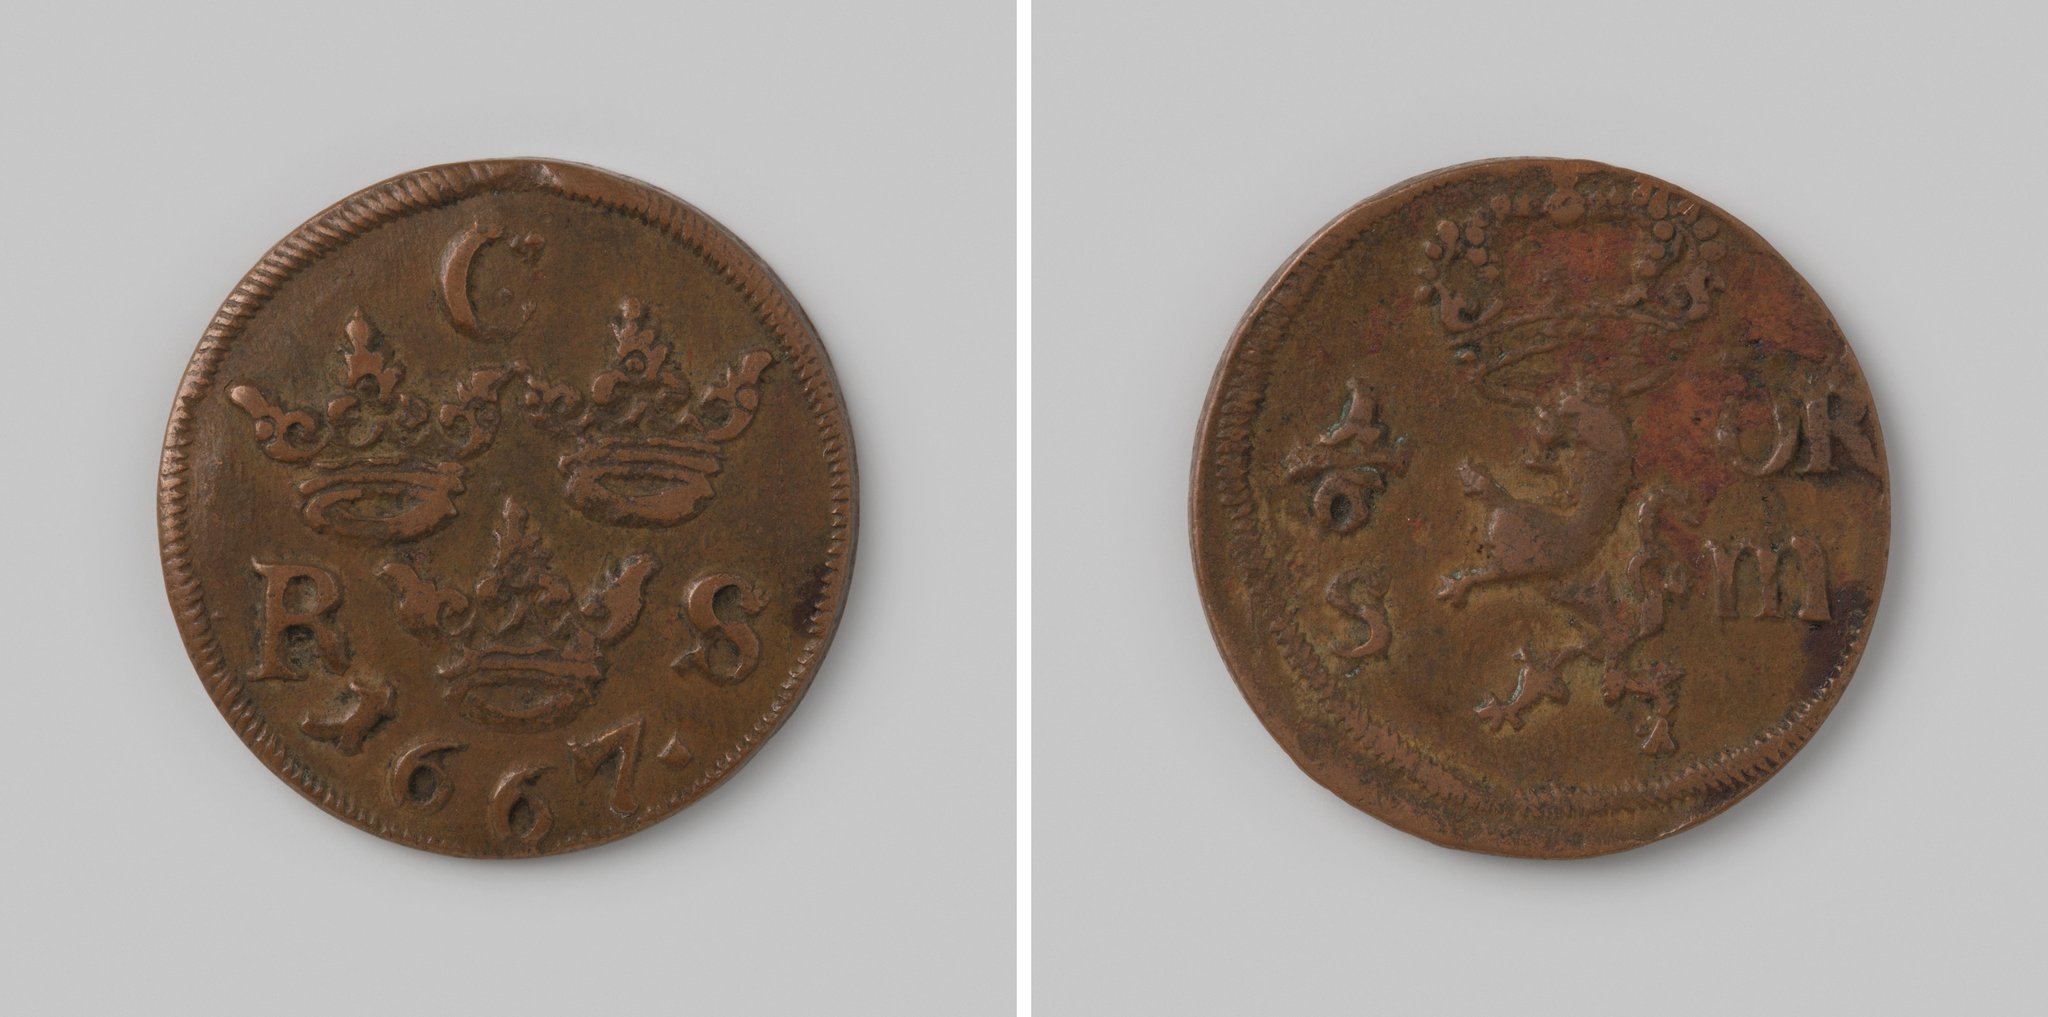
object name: coin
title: 1/6 öre Silver Mynt uit Zweden van Karel XI, 1667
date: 1667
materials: copper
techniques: striking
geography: slot rörstrand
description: Koperen munt. Voorzijde: tussen drie kronen letters C,R en S. Daaronder jaartal. Keerzijde: tussen waarde-aanduiding leeuw, waarboven kroon. Gladde rand.